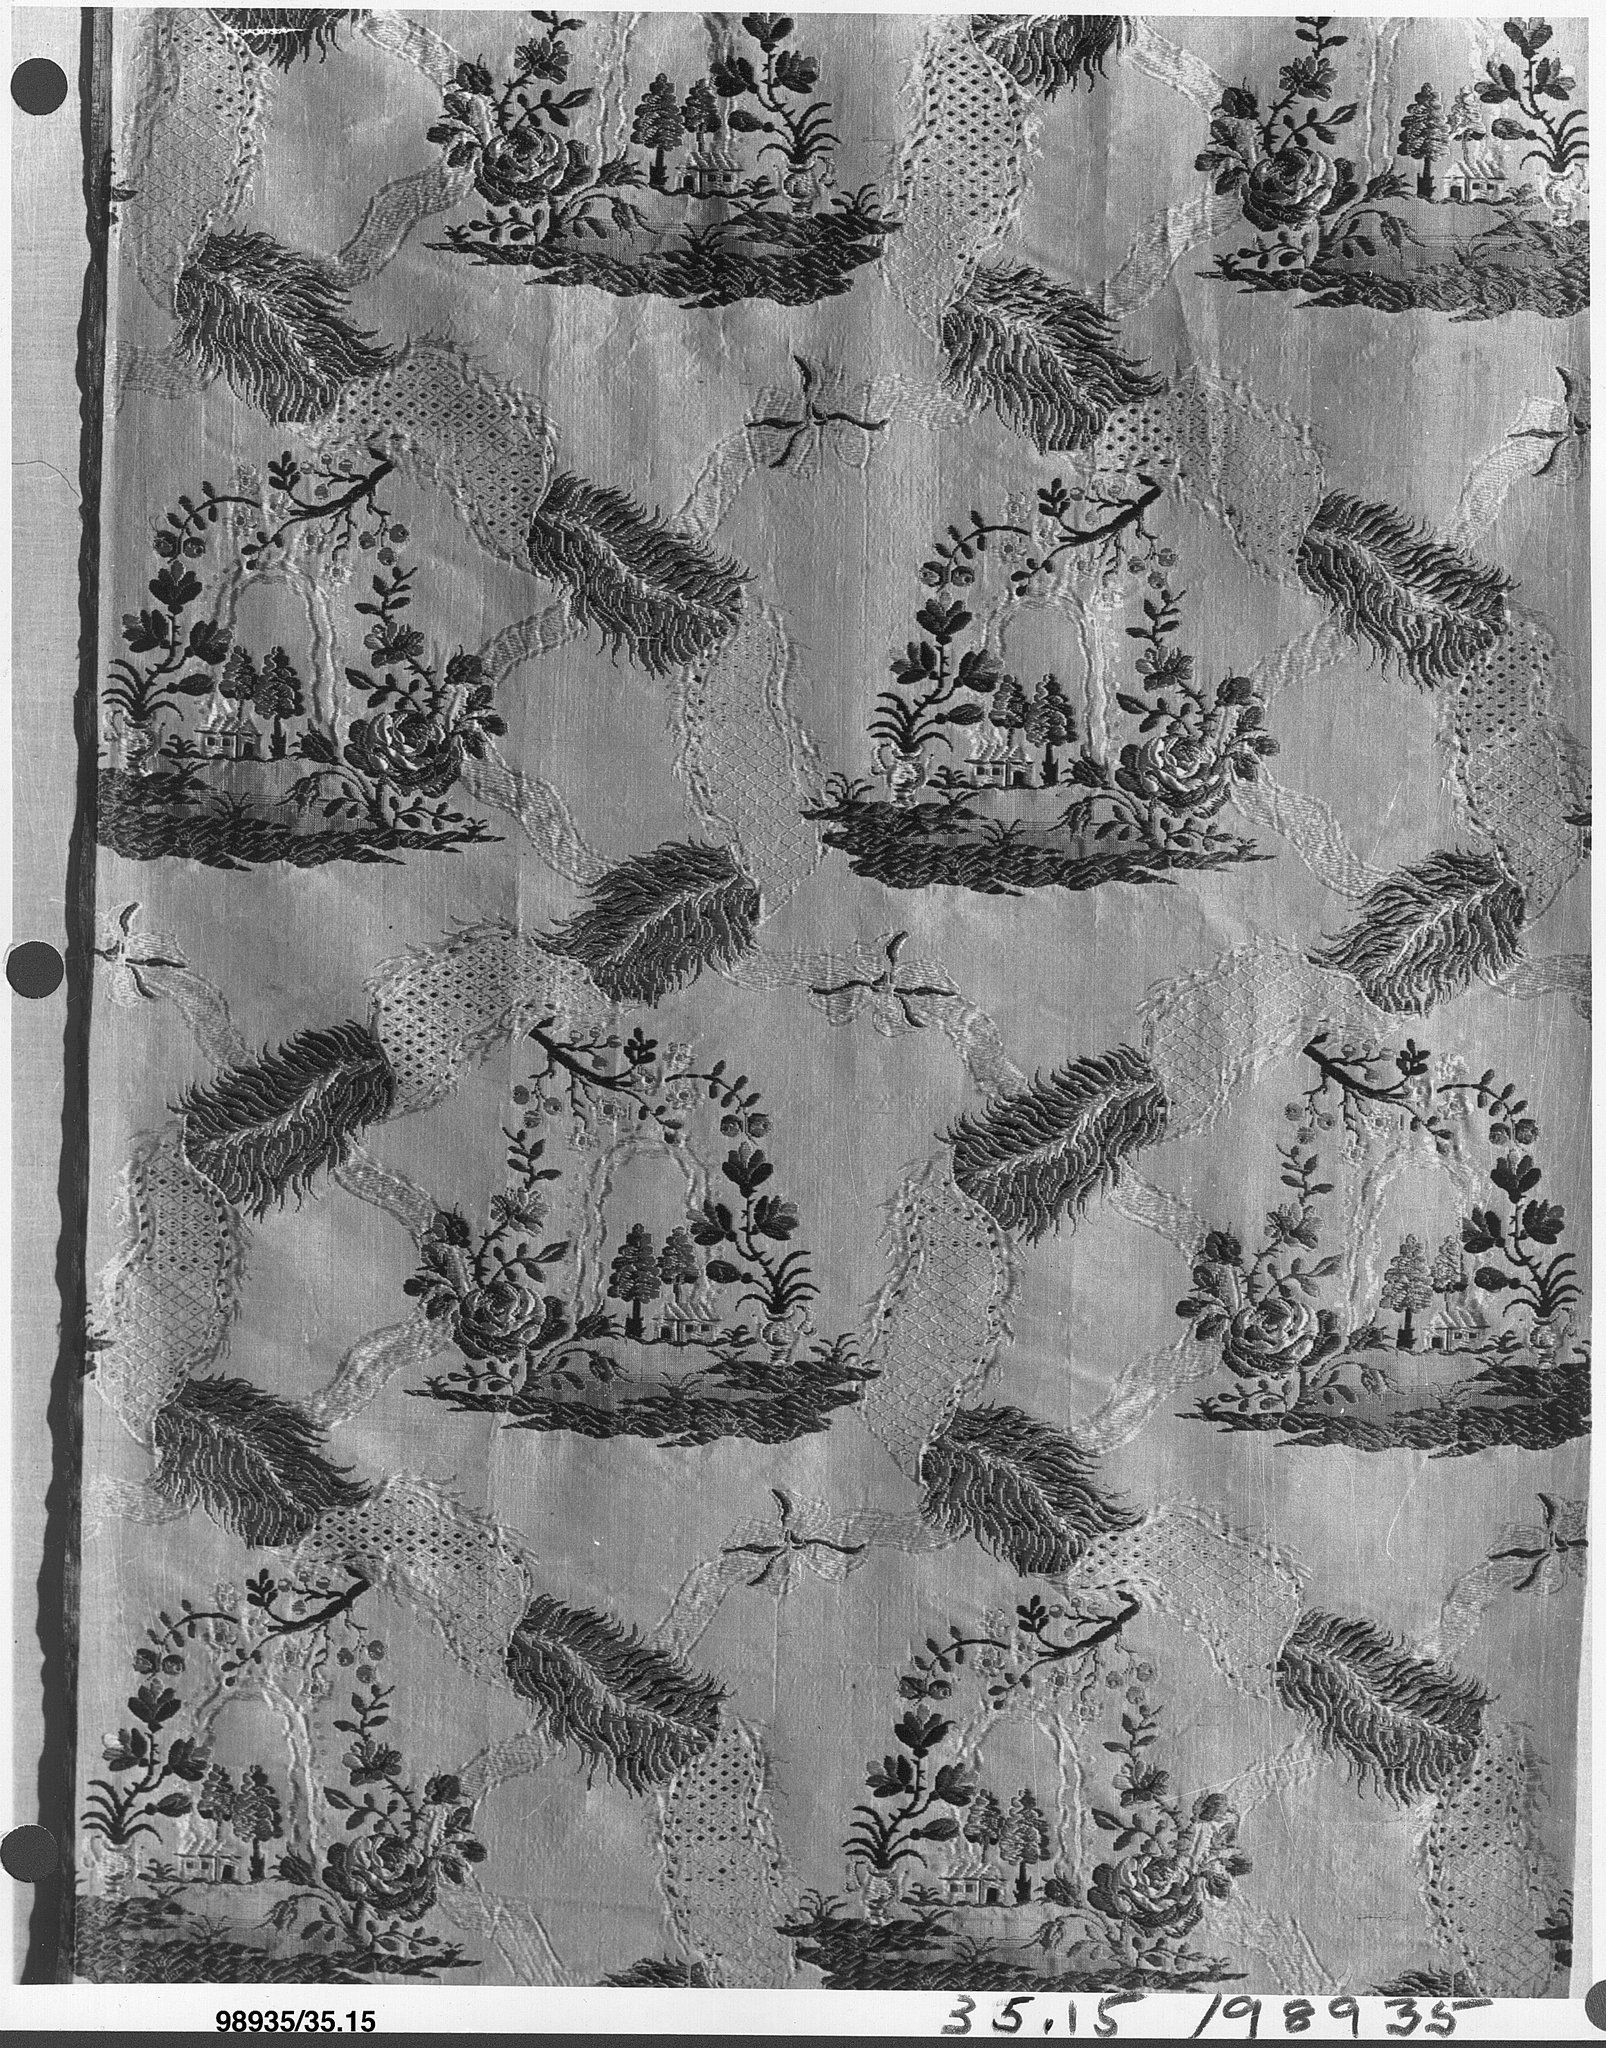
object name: piece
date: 1750-1760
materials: silk